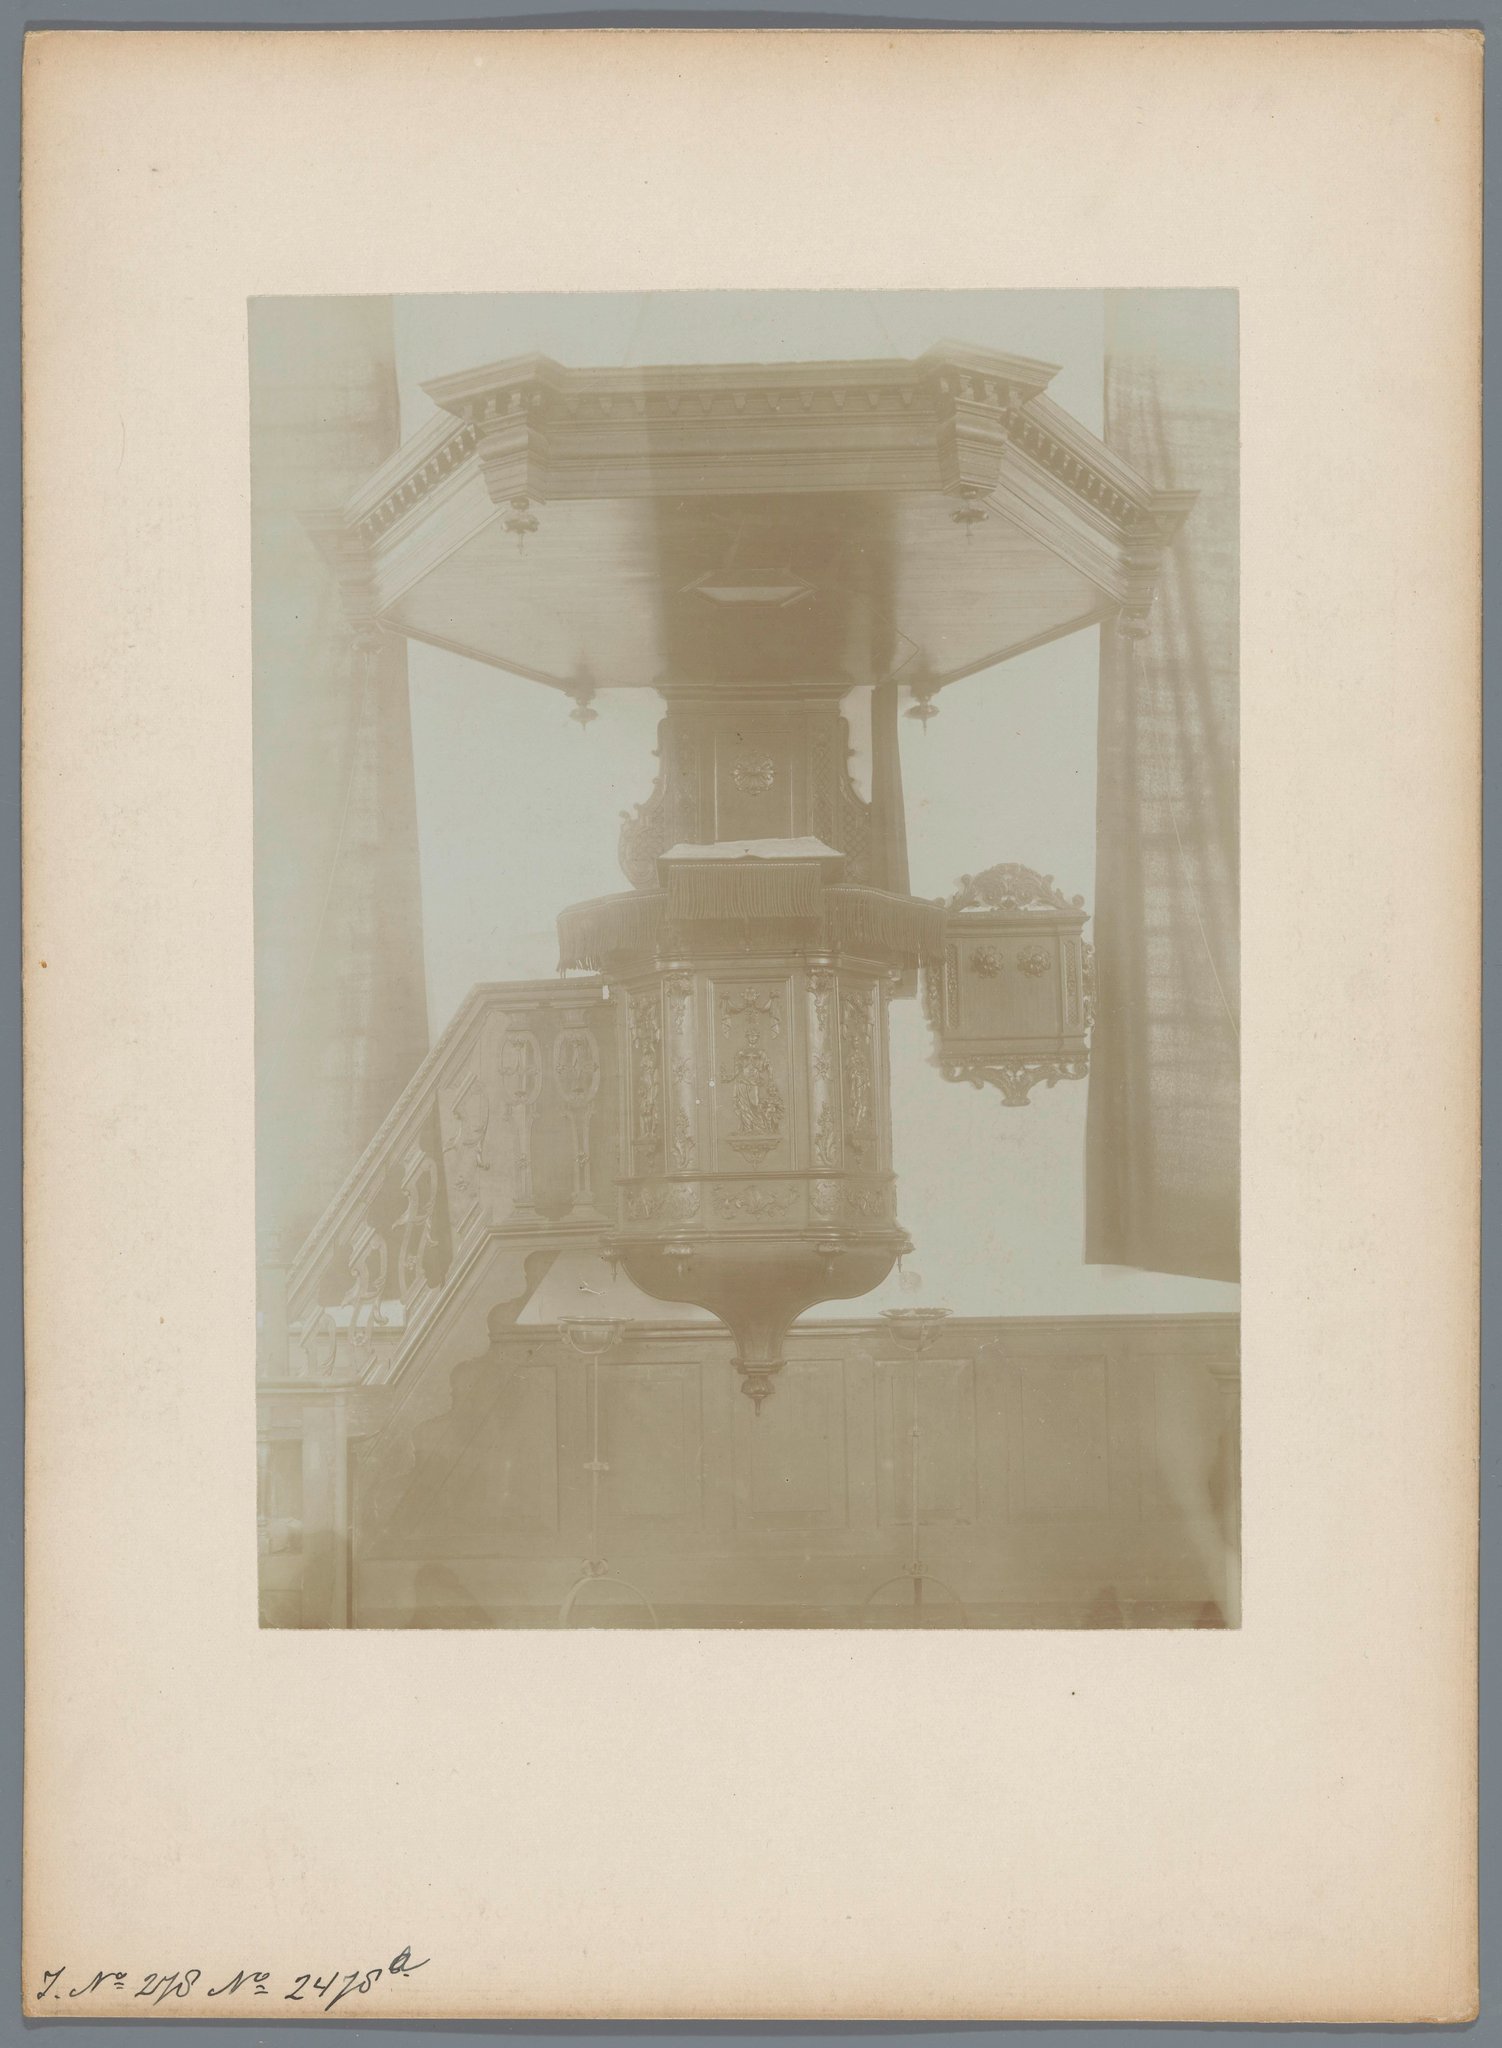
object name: photograph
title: Preekstoel in de Grote Kerk te Drachten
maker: Anonymous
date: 1910-1915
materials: cardboard, photographic support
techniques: collodion silver print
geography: grote kerk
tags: interior of church, pulpit, ambo, chancel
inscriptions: inscription: ‘5717 neg. no 16971’, inscription: ‘Drachten. Preekstoel in N.H. kerk Oct. 1915’, annotation